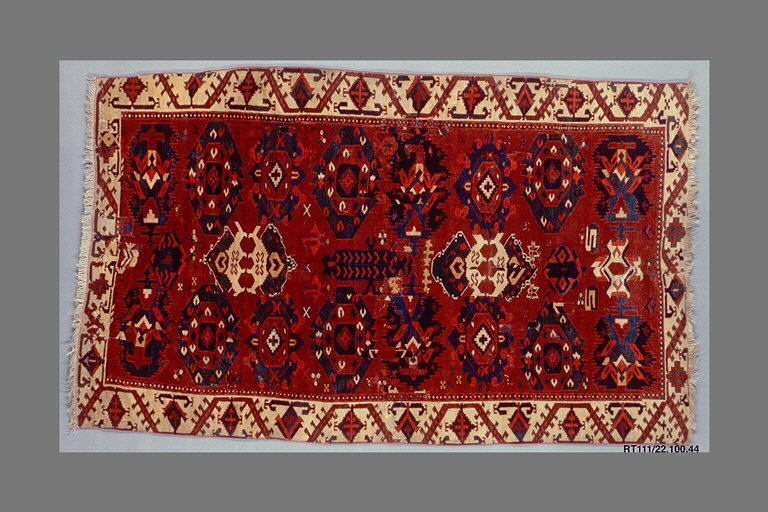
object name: carpet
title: Yamut Main Carpet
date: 1767-1833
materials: wool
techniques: pile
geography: western turkmenistan